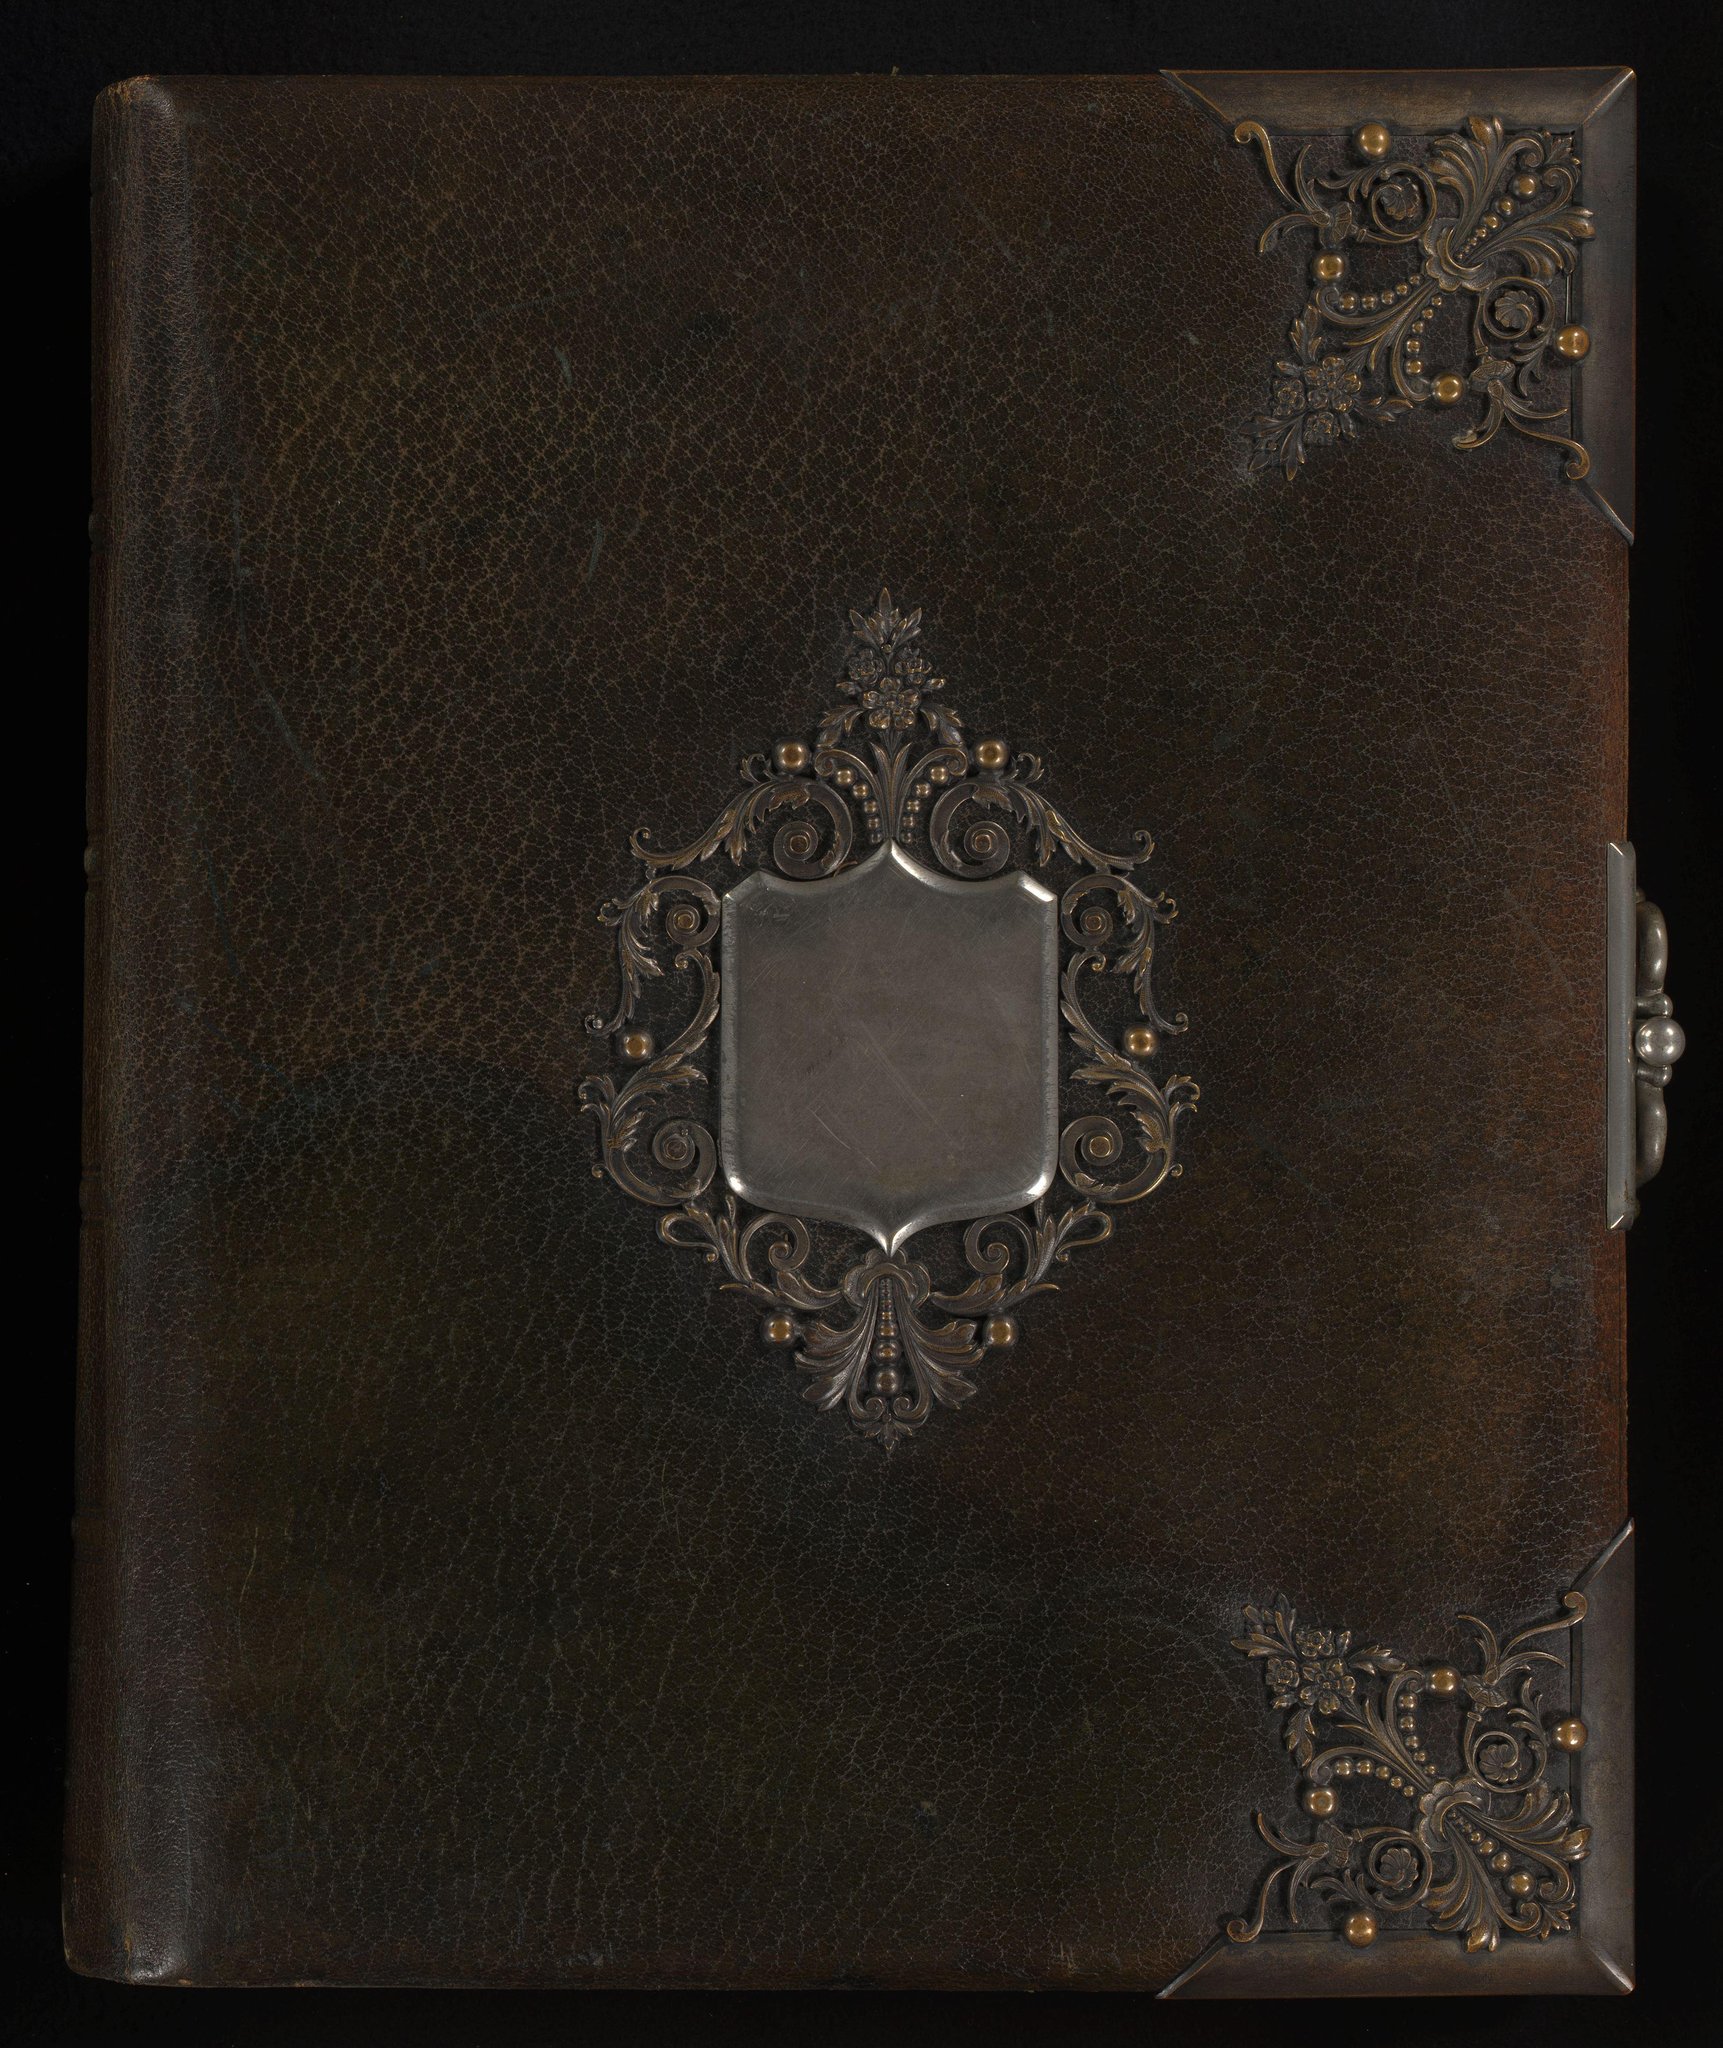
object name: photograph album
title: Frans familiealbum met 81 foto's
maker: Anonymous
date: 1860-1920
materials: cardboard, leather, metal, paper, photographic support, silk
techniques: albumen print, gelatin silver print, platinum process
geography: france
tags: historical persons - bb - woman, child, historical persons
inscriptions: collector's mark: ‘DIENST/ VERSPREIDE/ RIJKSKOLLEKTIES/ (...) A 685’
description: Fotoalbum met 32 pagina's met in totaal 81 foto's. Het album bevat 16 kabinetfoto's en 64 cartes-de-visite in met gouden lijnen omkaderde passe-partouts en een miniatuurportret dat in de passe-partout van RP-F-F00685-14-2 is gestoken. Afgebeeld zijn portretten van leden van een Franse familie. Bij een deel van de foto's is onder de passe-partout de naam van de geportretteerde vermeld. De achternamen Ernie, Verluise, Arvisenet, Epaulard en Guétin zijn meerdere malen vermeld. De foto's zijn gemaakt door verschillende fotografen, waaronder L. Larger, Jamin en Eugène Pirou. Van 4 foto's is de fotograaf anoniem.